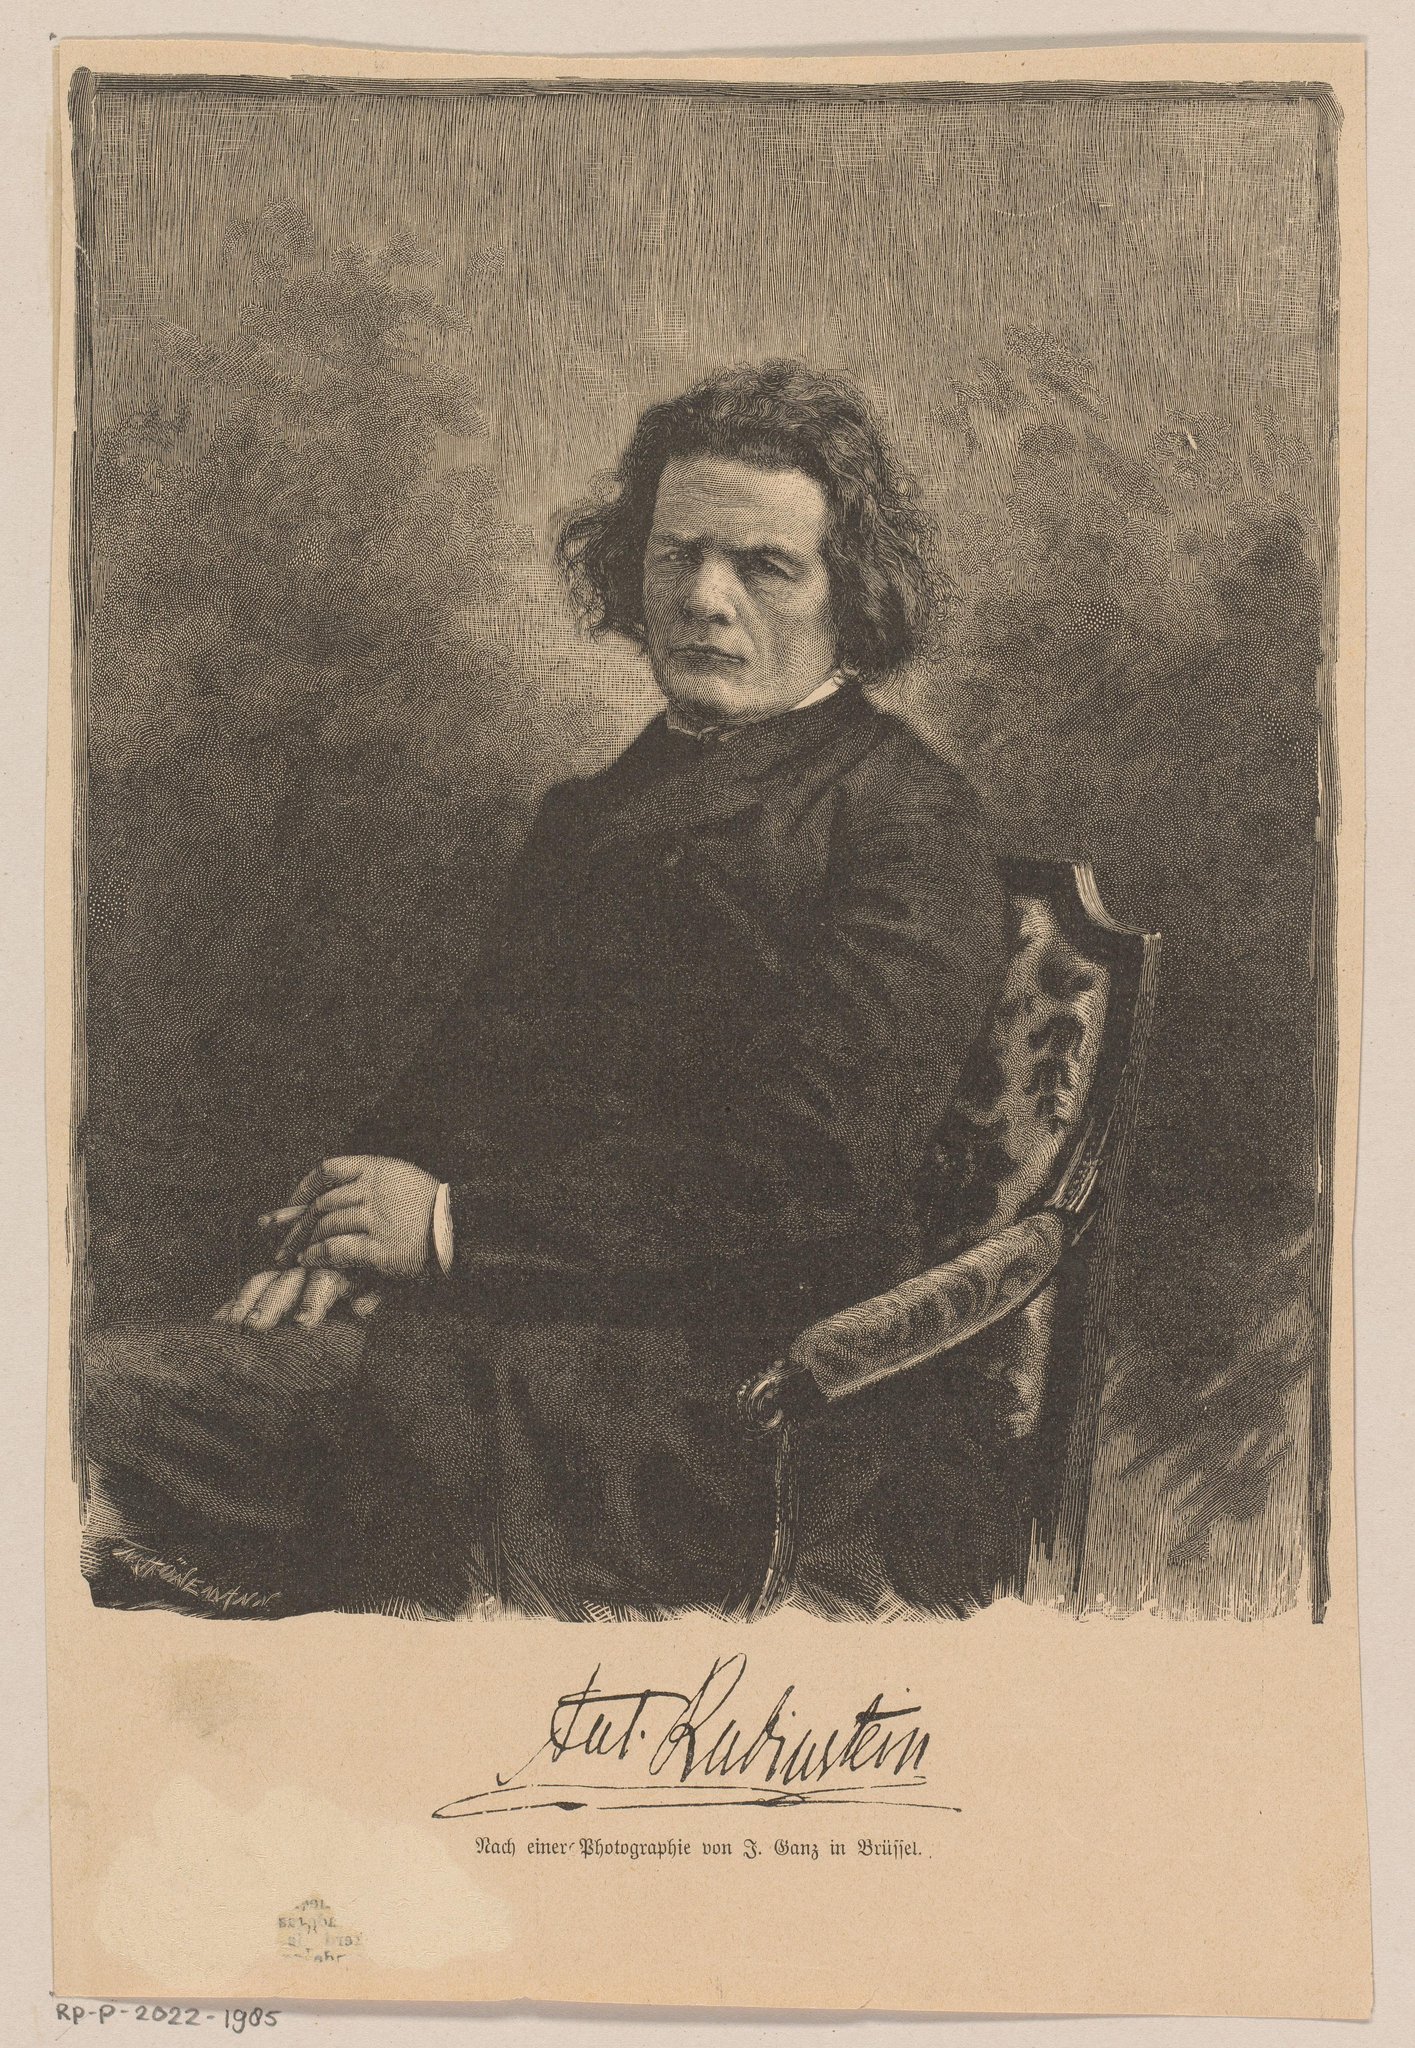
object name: print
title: Portret van Anton Rubinstein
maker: martin hönemann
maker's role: print maker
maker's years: 1858-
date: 1868-1899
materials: paper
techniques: letterpress printing, engraving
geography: brussels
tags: historical persons, portrait of composer